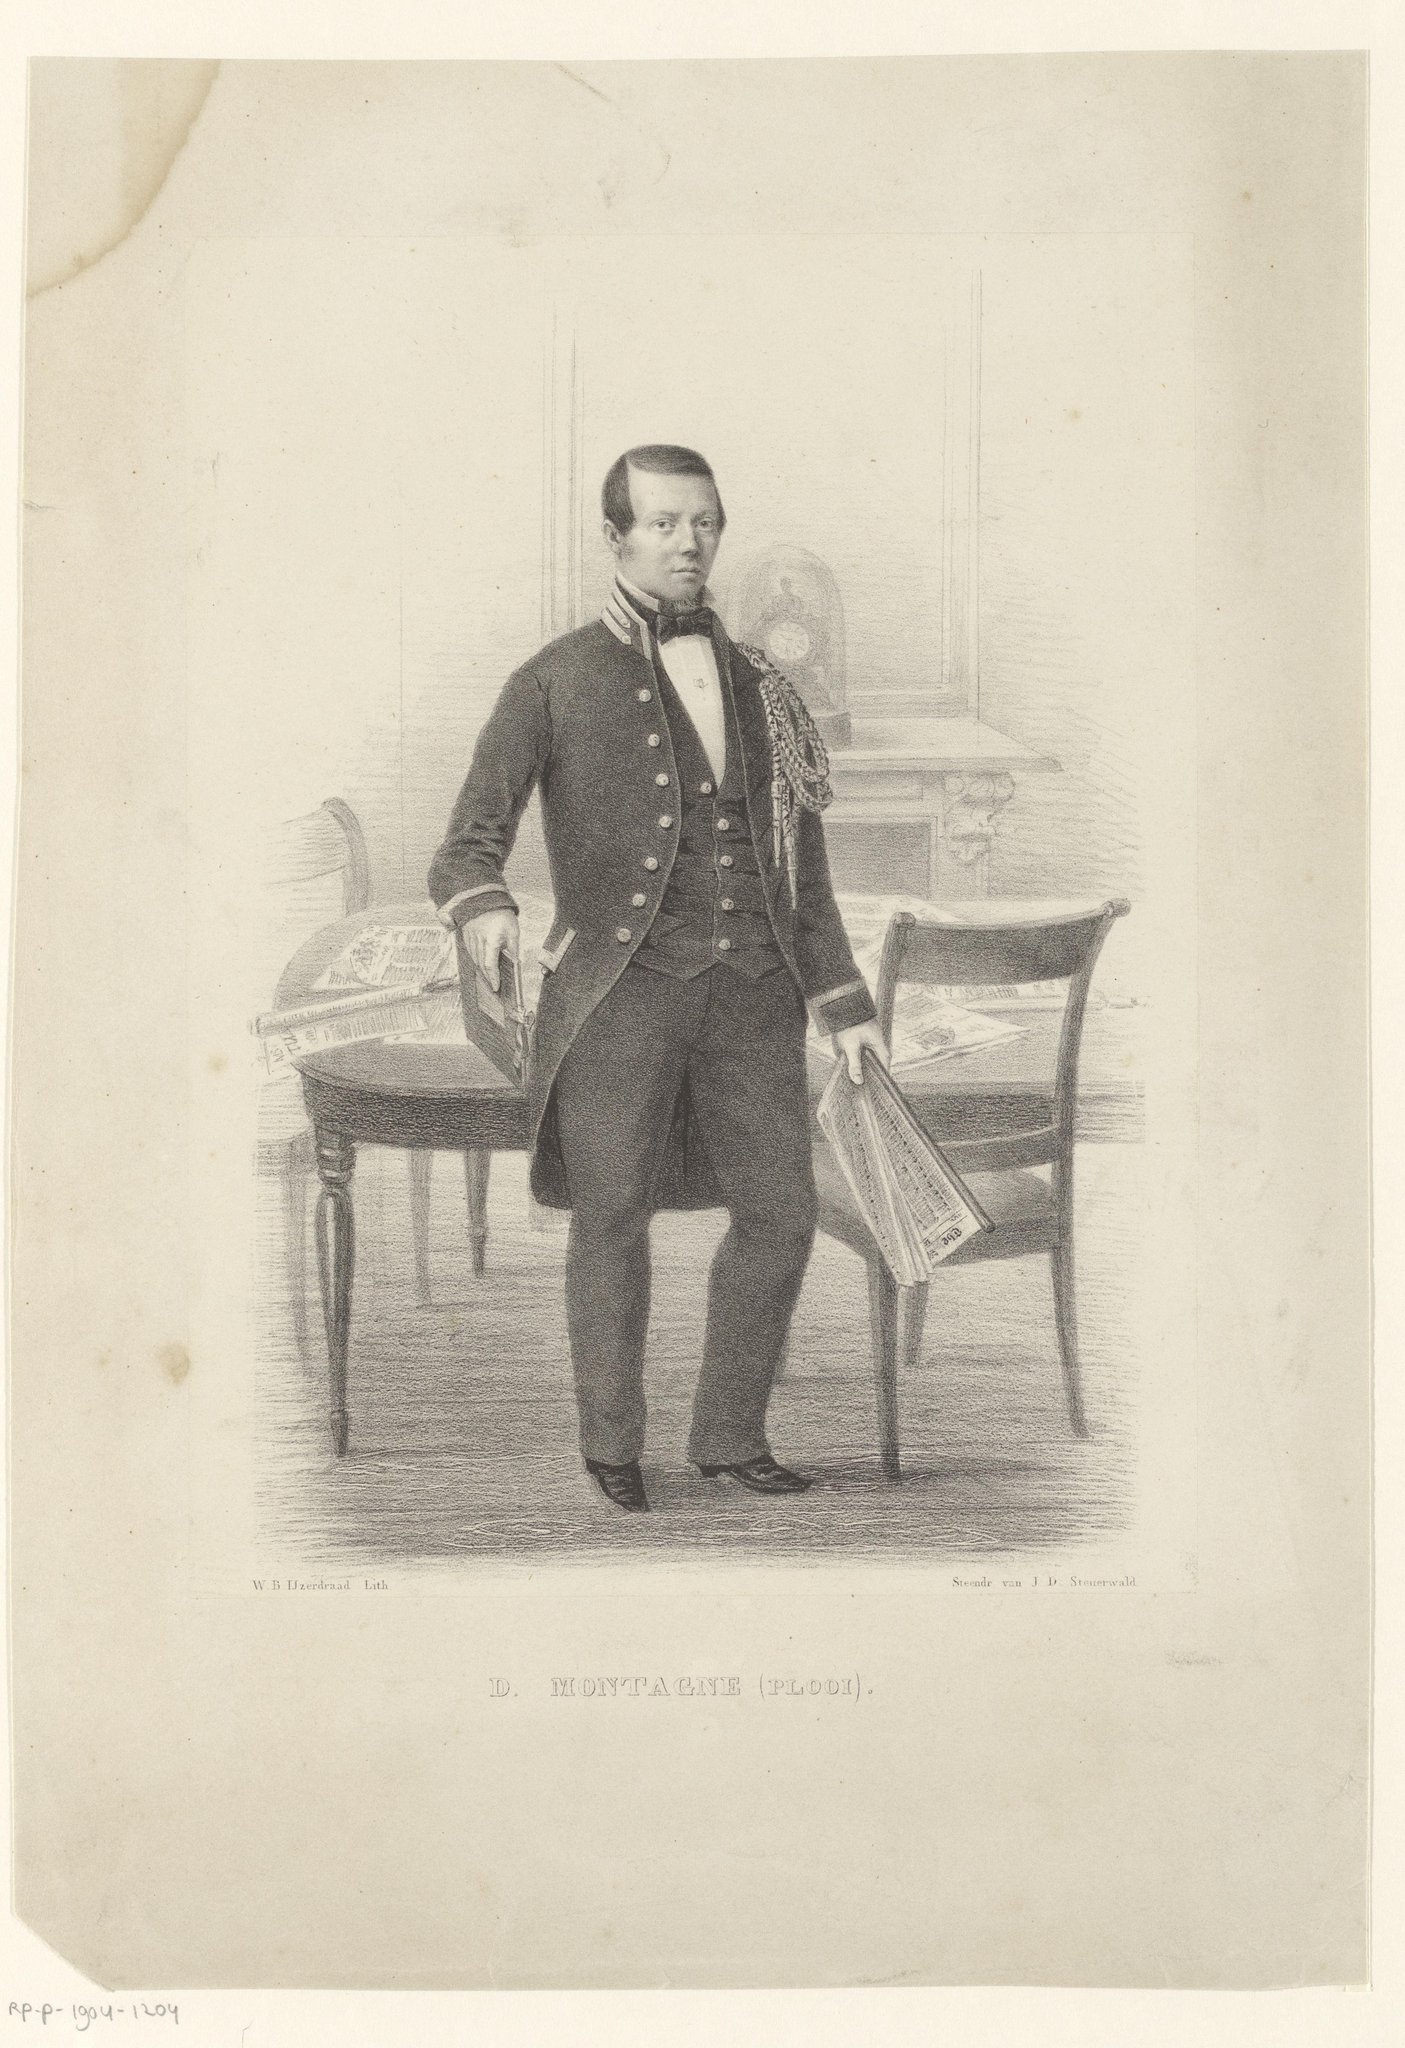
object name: print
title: Portret van D. Montagne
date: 1845-1863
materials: paper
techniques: lithograph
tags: newspaper, news-sheet, historical persons (+ full length portrait)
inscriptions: collector's mark: Lugt 2228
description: De geportretteerde staat voor een tafel met kranten. In zijn linkerhand heeft hij een krant, in zijn rechterhand een map.